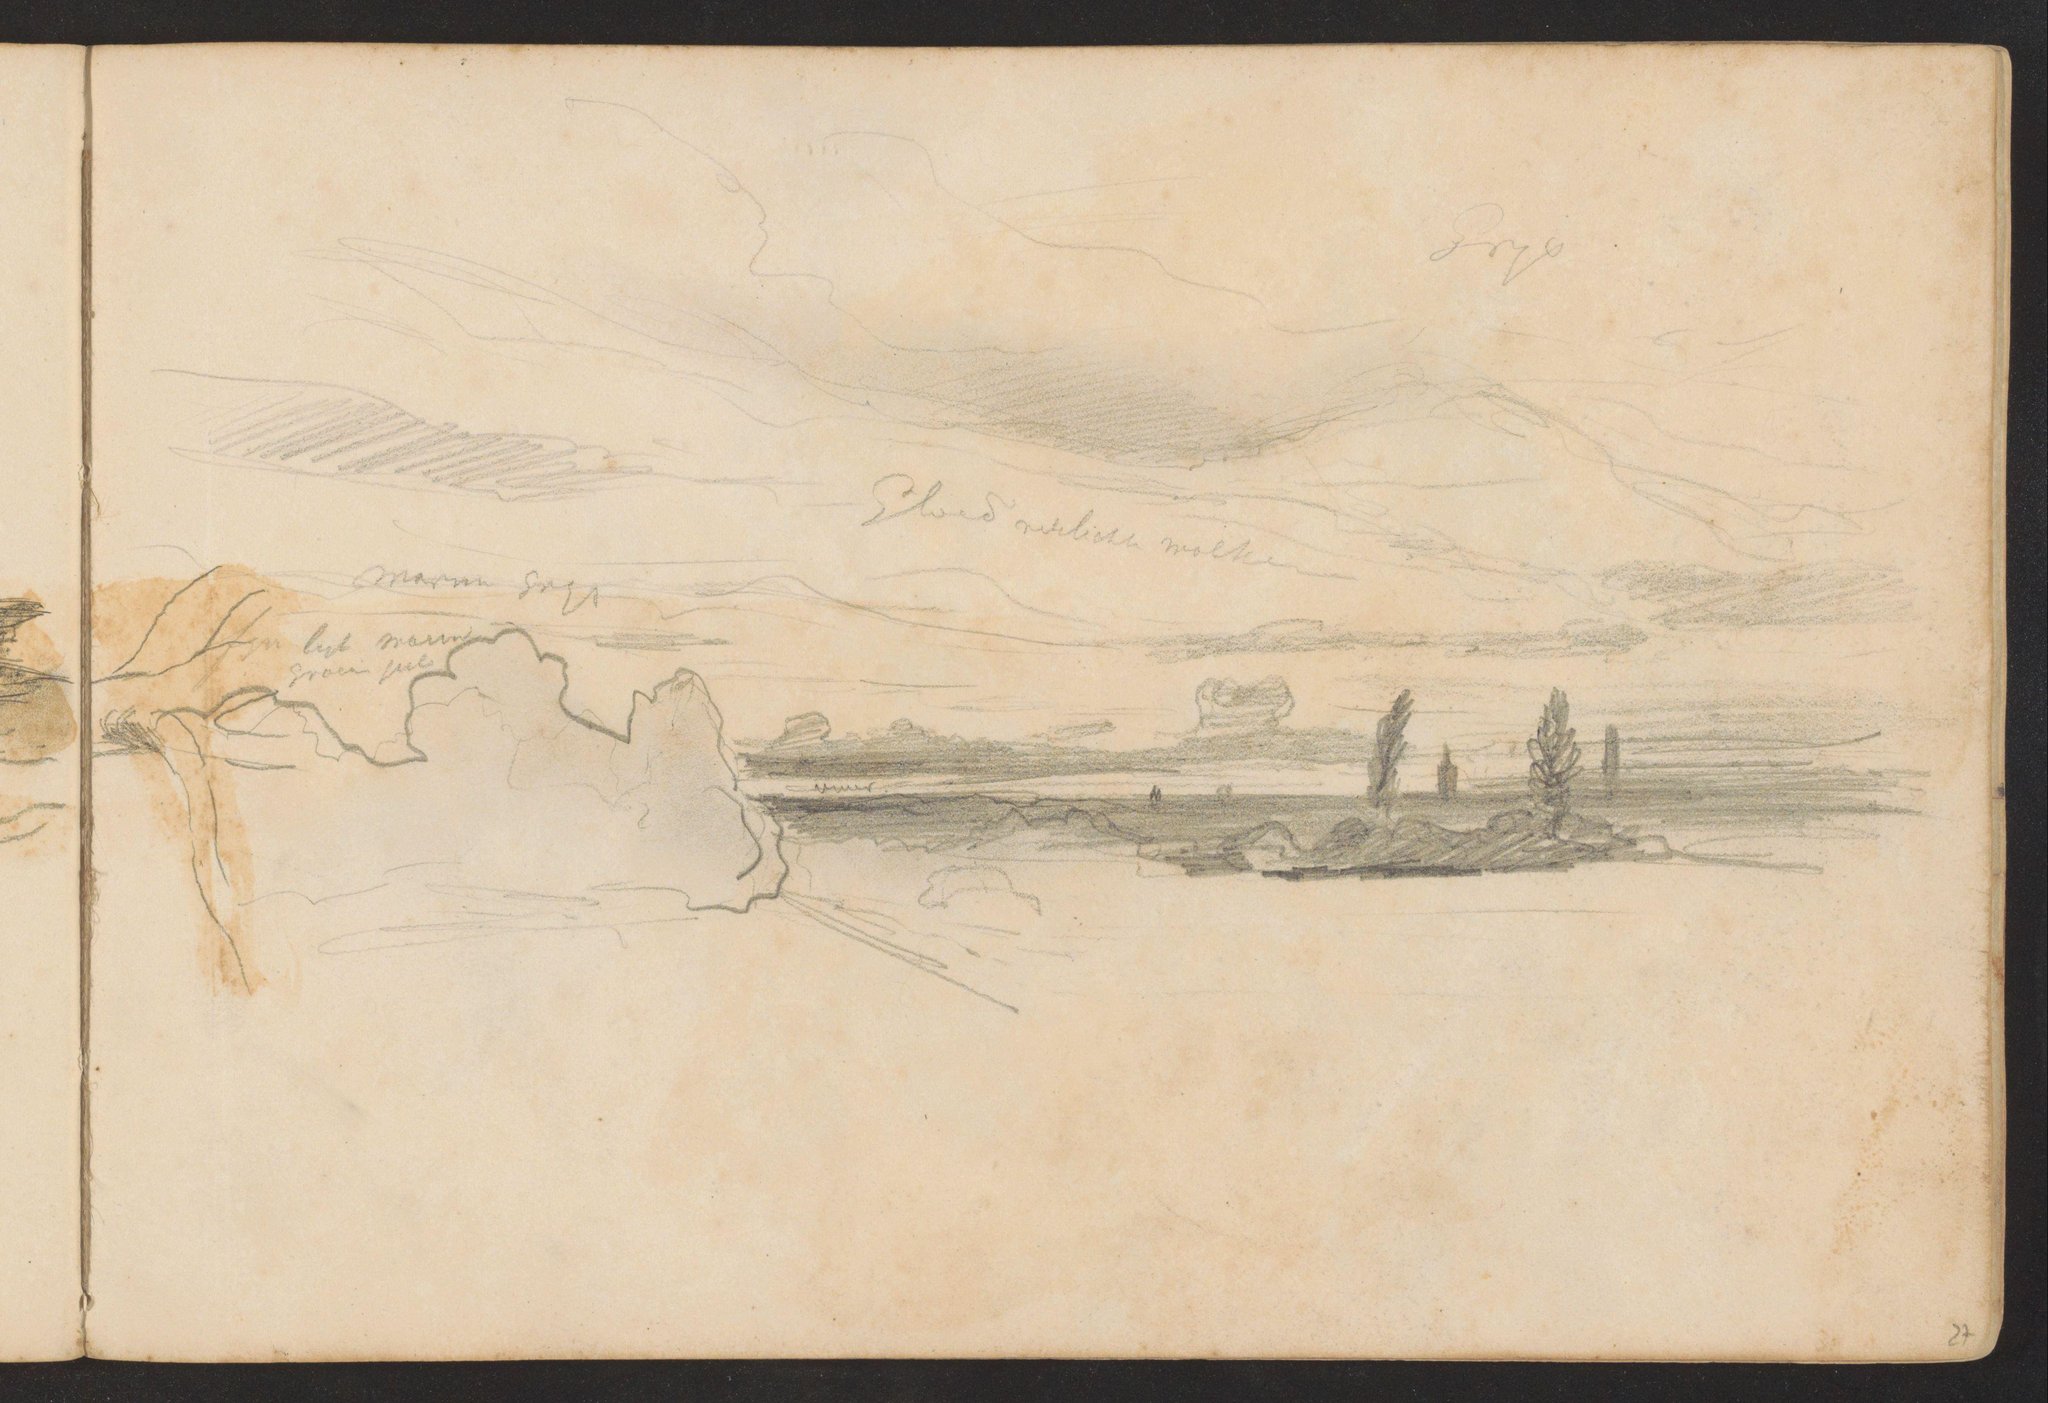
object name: sketchbook leaf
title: Vlak landschap met een rivier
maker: johannes tavenraat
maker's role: draughtsman, painter, print maker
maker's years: 1809-1881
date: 1842-1868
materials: paper, pencil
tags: river, landscapes with waters, waterscapes, seascapes (in the temperate zone)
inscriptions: kleurnotitie, handgeschreven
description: Blad 27 recto in een schetsboek met 45 bladen.